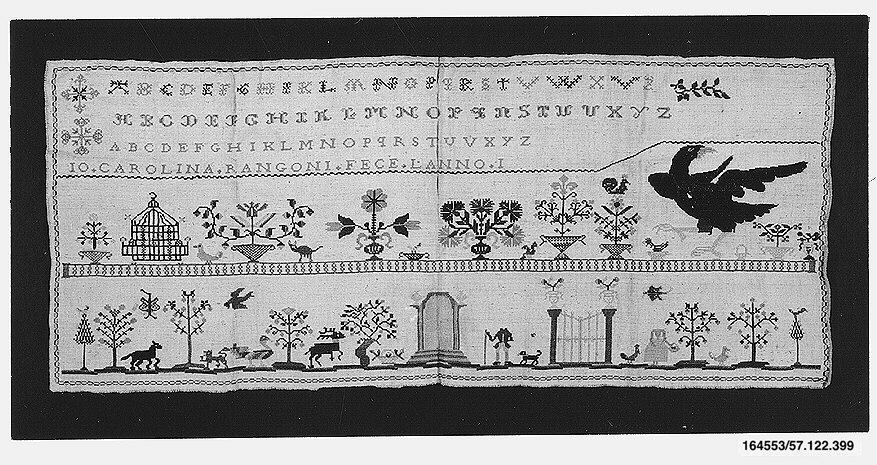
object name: sampler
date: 1801-1900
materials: cotton, linen, silk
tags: animals,birds,flowers